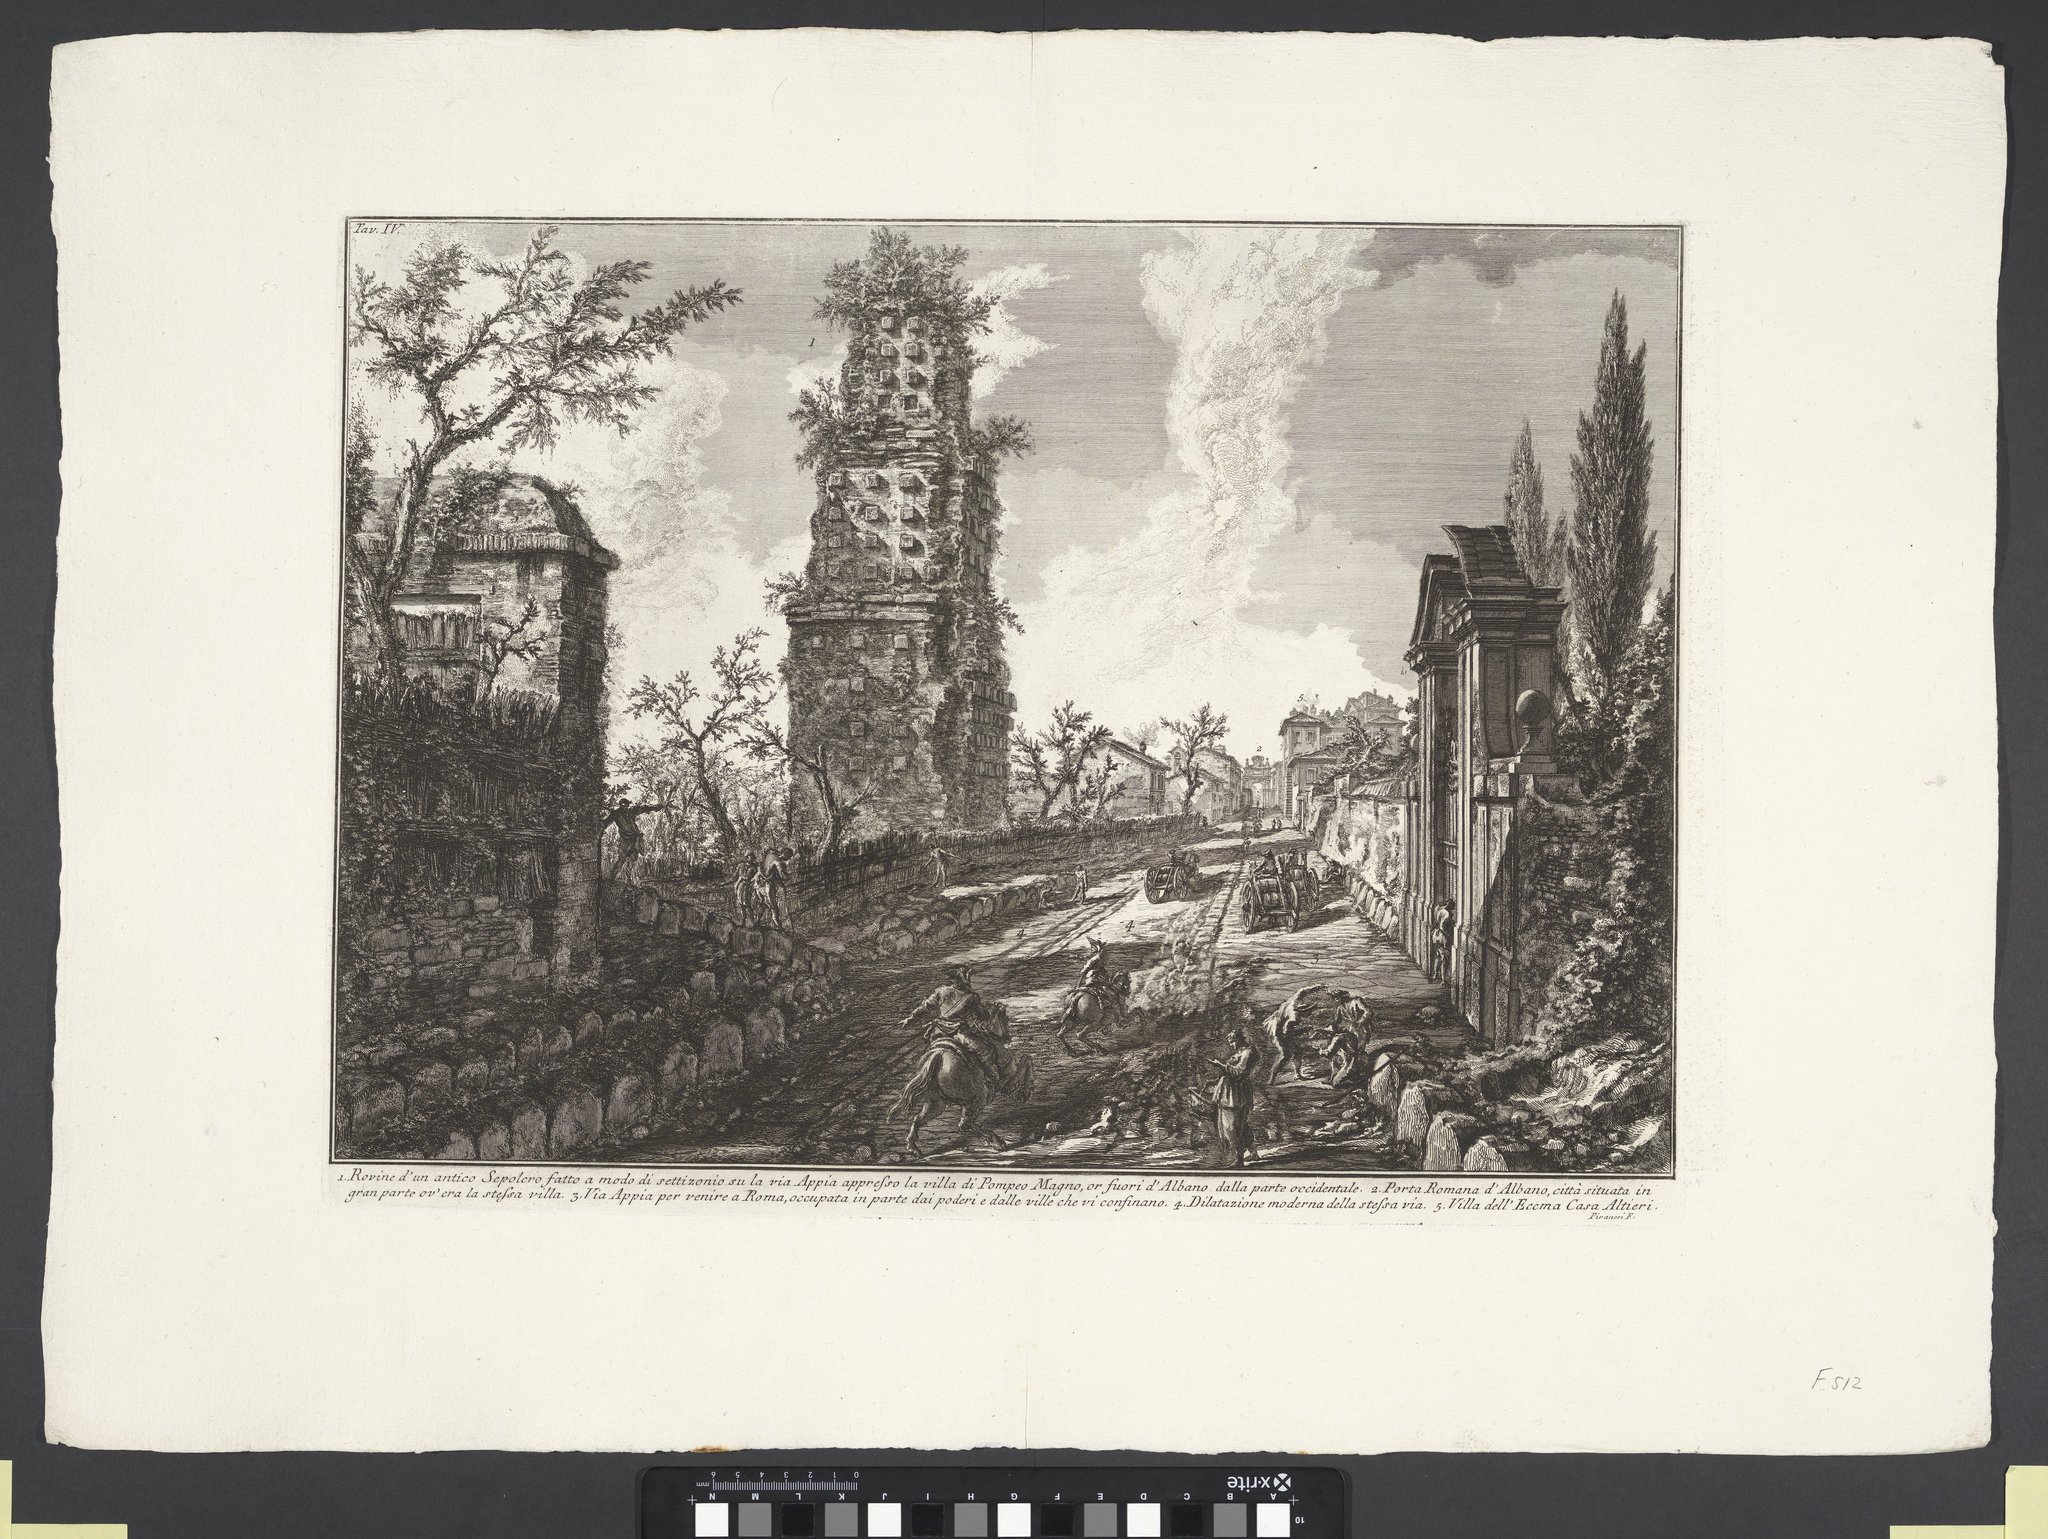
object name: print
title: Archeologische vondsten uit Albano en Castel Gandolfo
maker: giovanni battista piranesi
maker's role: designer, draughtsman, print maker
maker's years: 1720-1778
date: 1764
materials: paper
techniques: etching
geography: rome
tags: city-view, and landscape with man-made constructions, ruin of a building ~ architecture, landscape with ruins, grave, tomb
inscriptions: collector's mark: Lugt 2228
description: Gezicht op de resten van een graftombe aan de Via Appia Antica bij Albano, in de buurt van de Villa van Gnaeus Pompeius Magnus. Verklarende lijst met nummers in ondermarge. Genummerd linksboven: Tav. IV.